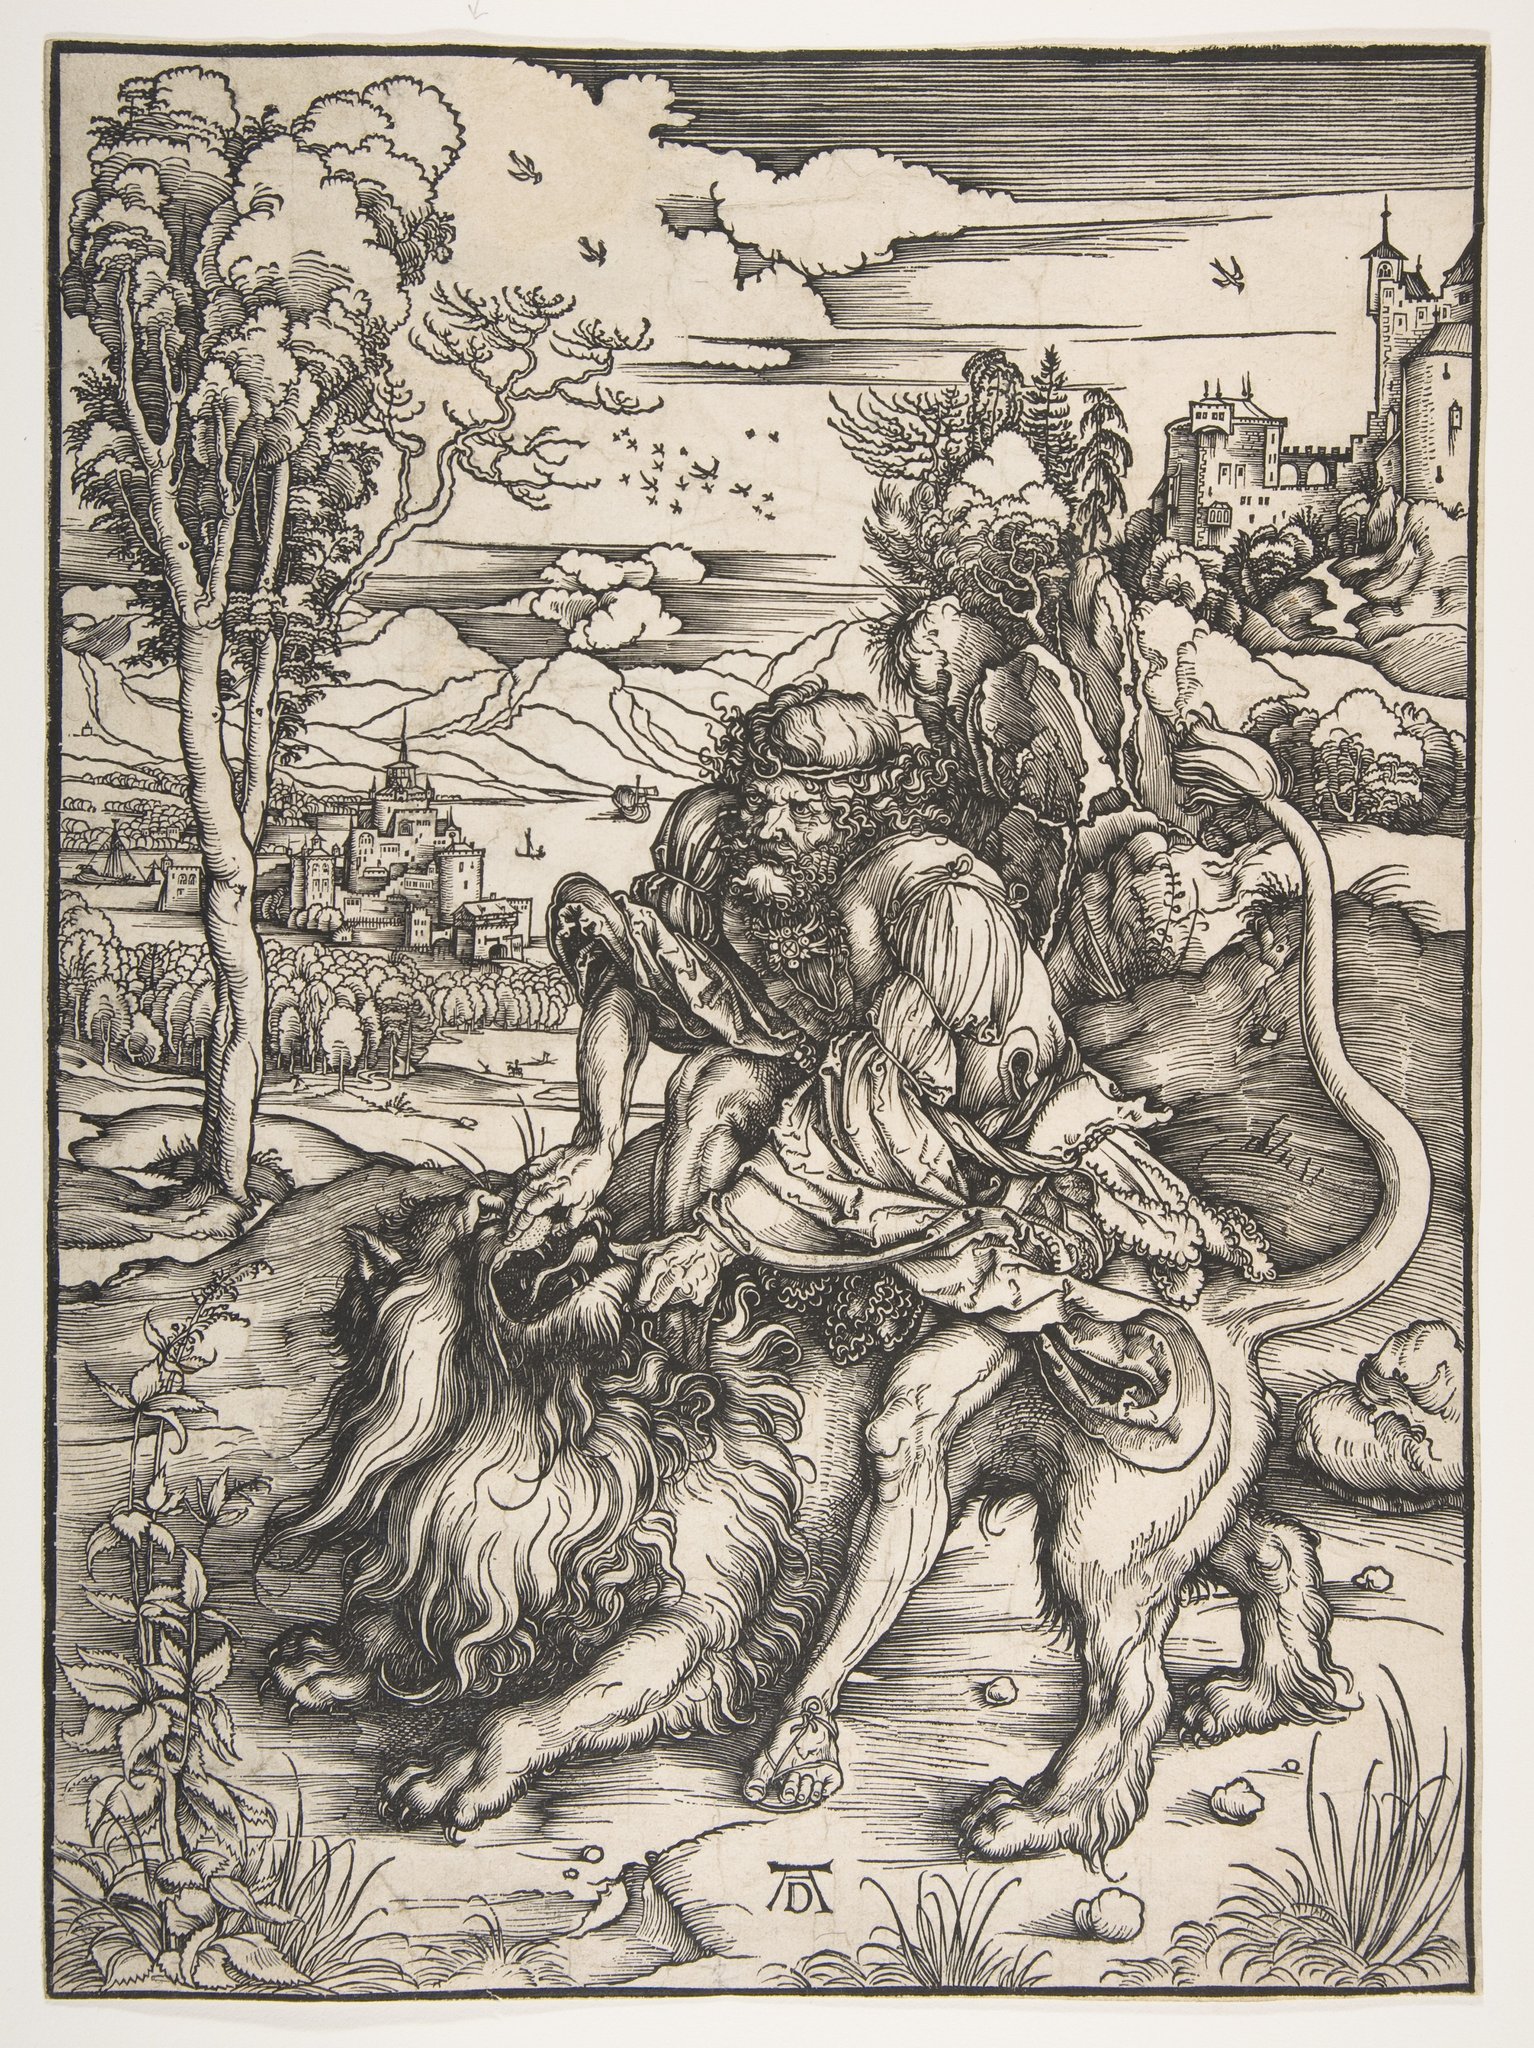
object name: print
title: Samson Rending the Lion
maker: albrecht dürer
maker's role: artist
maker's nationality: german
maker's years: 1471-1528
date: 1497-1498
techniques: woodcut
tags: lions,samson